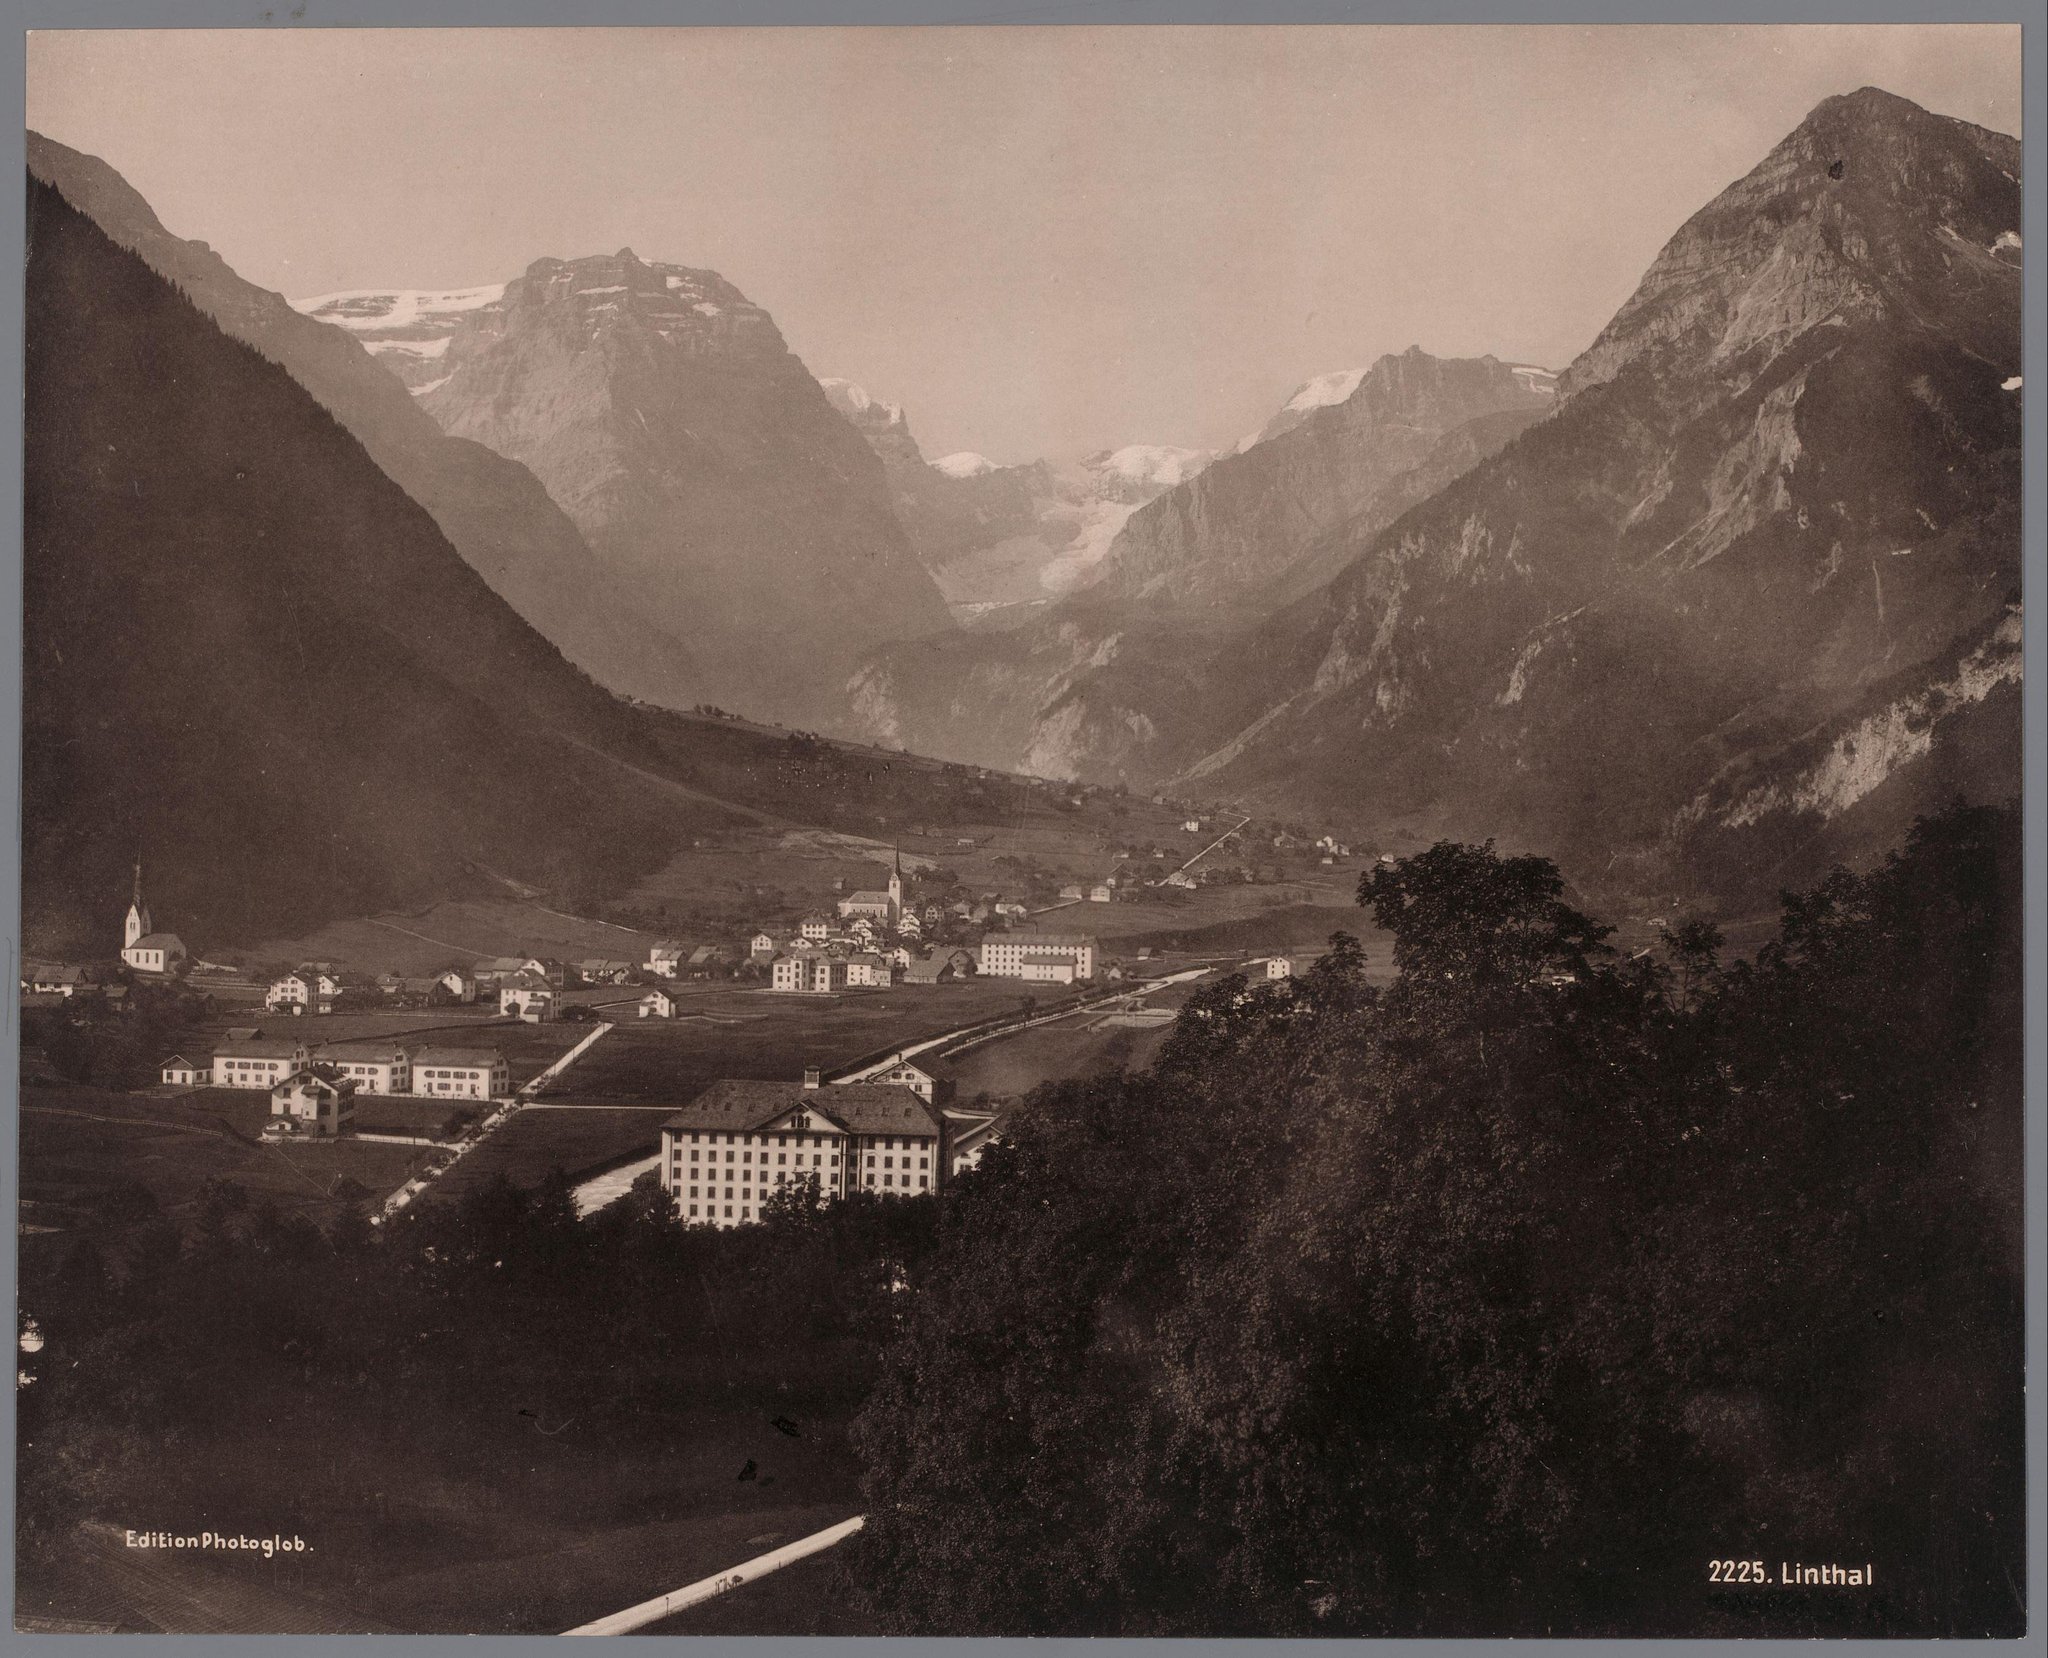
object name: photograph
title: Linthal, Zwitserland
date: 1890-1925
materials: paper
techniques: collodion silver print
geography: switzerland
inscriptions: inscription: ‘2225. Linthal’, inscription: ‘EditionPhotoglob.’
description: Gezicht op het dal met huizen. Gletsjers op de achtergrond. Linthal is de meest zuidelijke gemeente van het kanton Glarus.